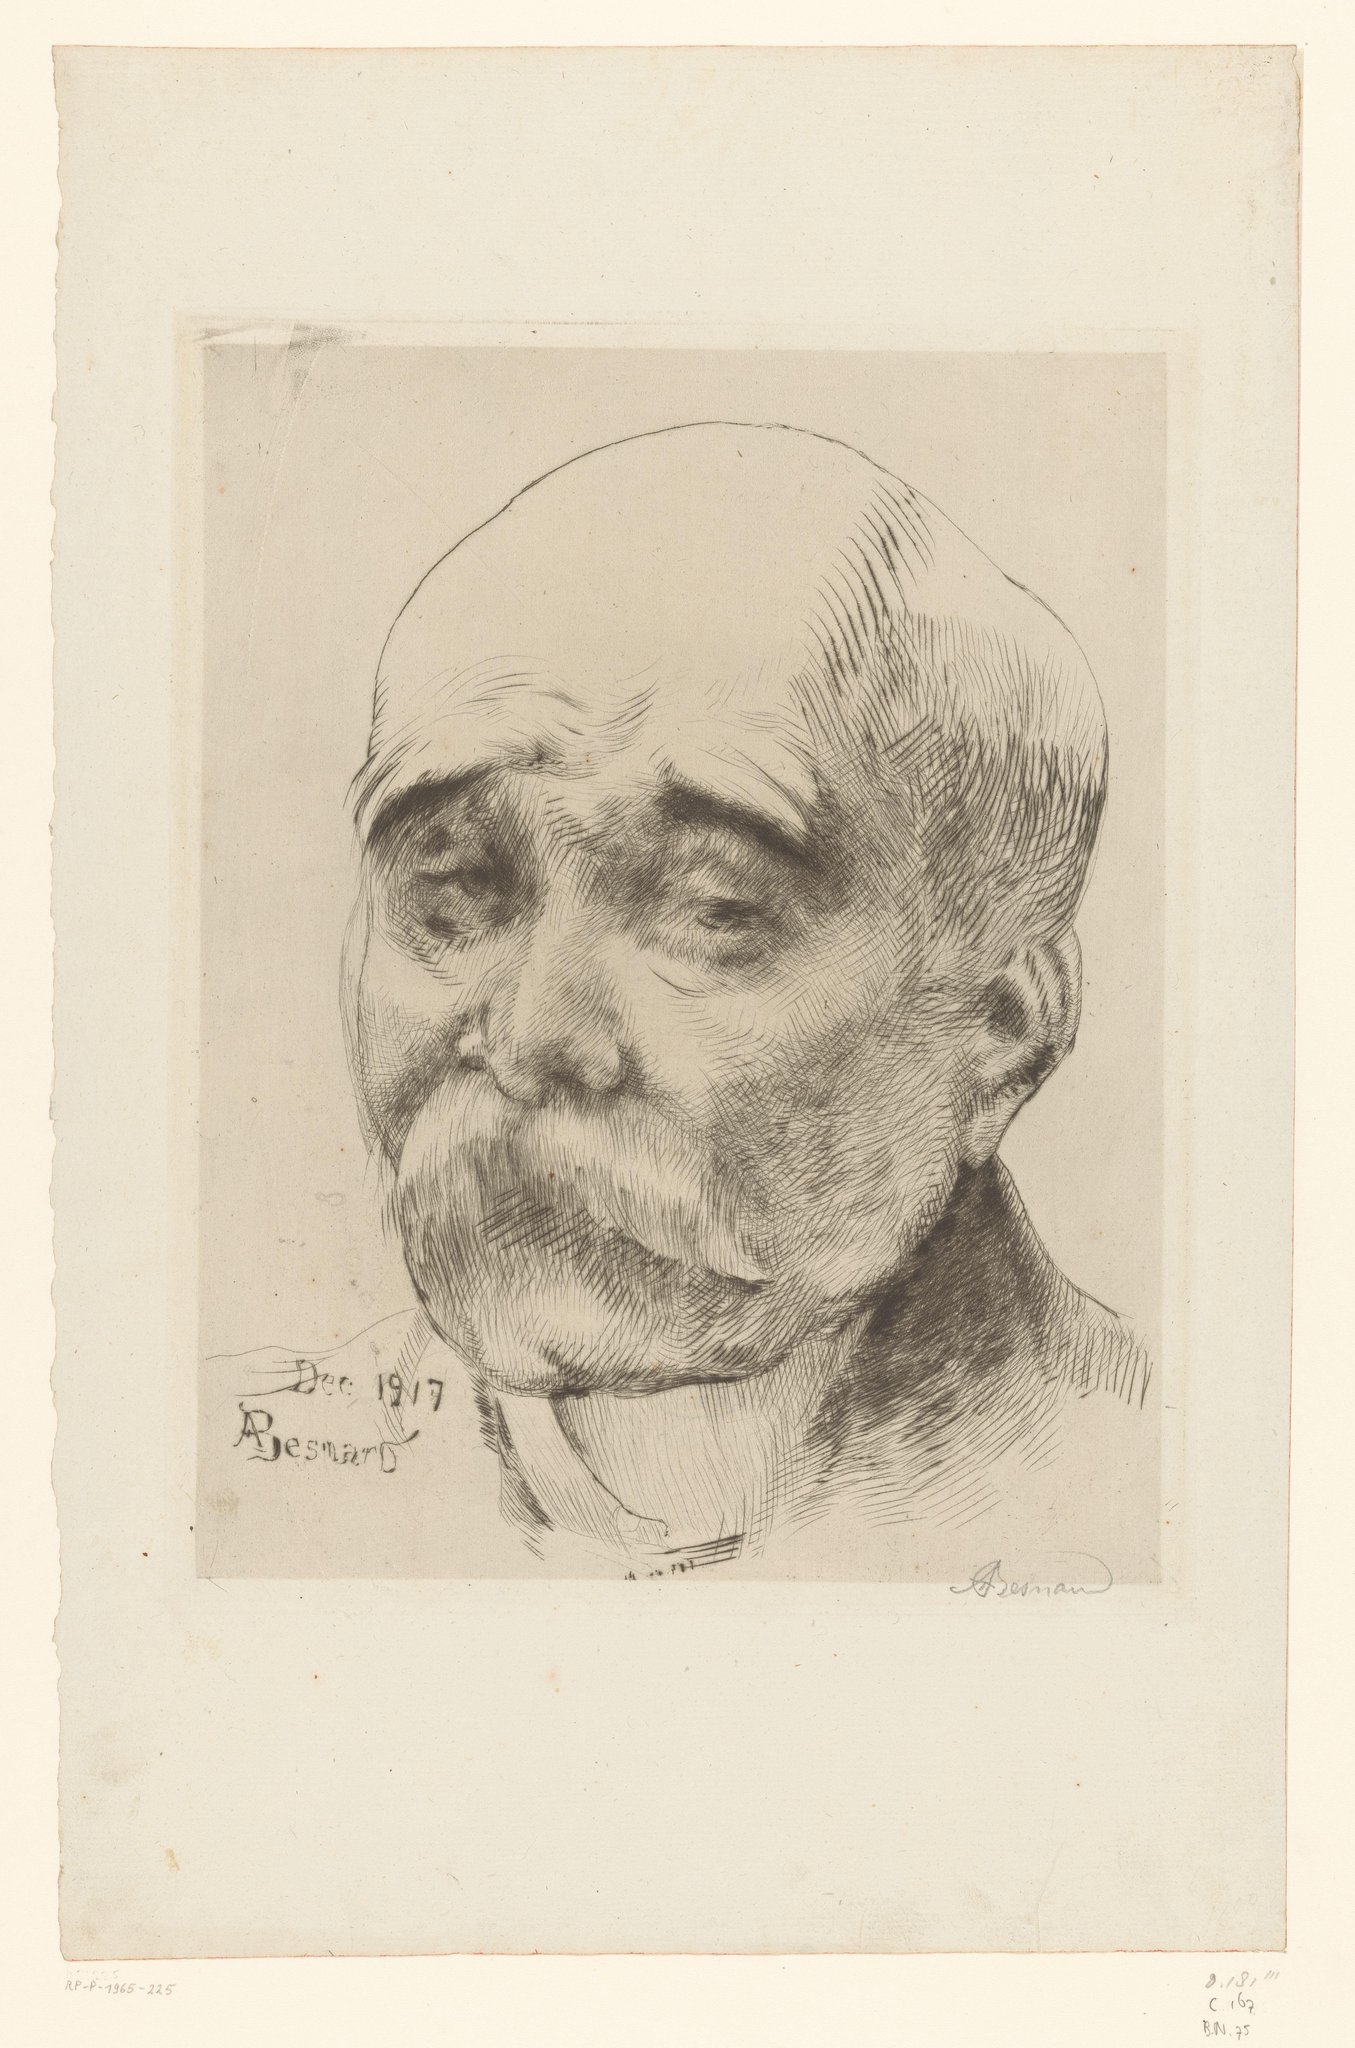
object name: print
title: Portret van Georges Clemenceau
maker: albert besnard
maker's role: draughtsman, print maker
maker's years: 1849-1934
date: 1917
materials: paper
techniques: drypoint, etching, intaglio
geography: france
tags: paris, politician, historical persons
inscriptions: collector's mark: Lugt 2228